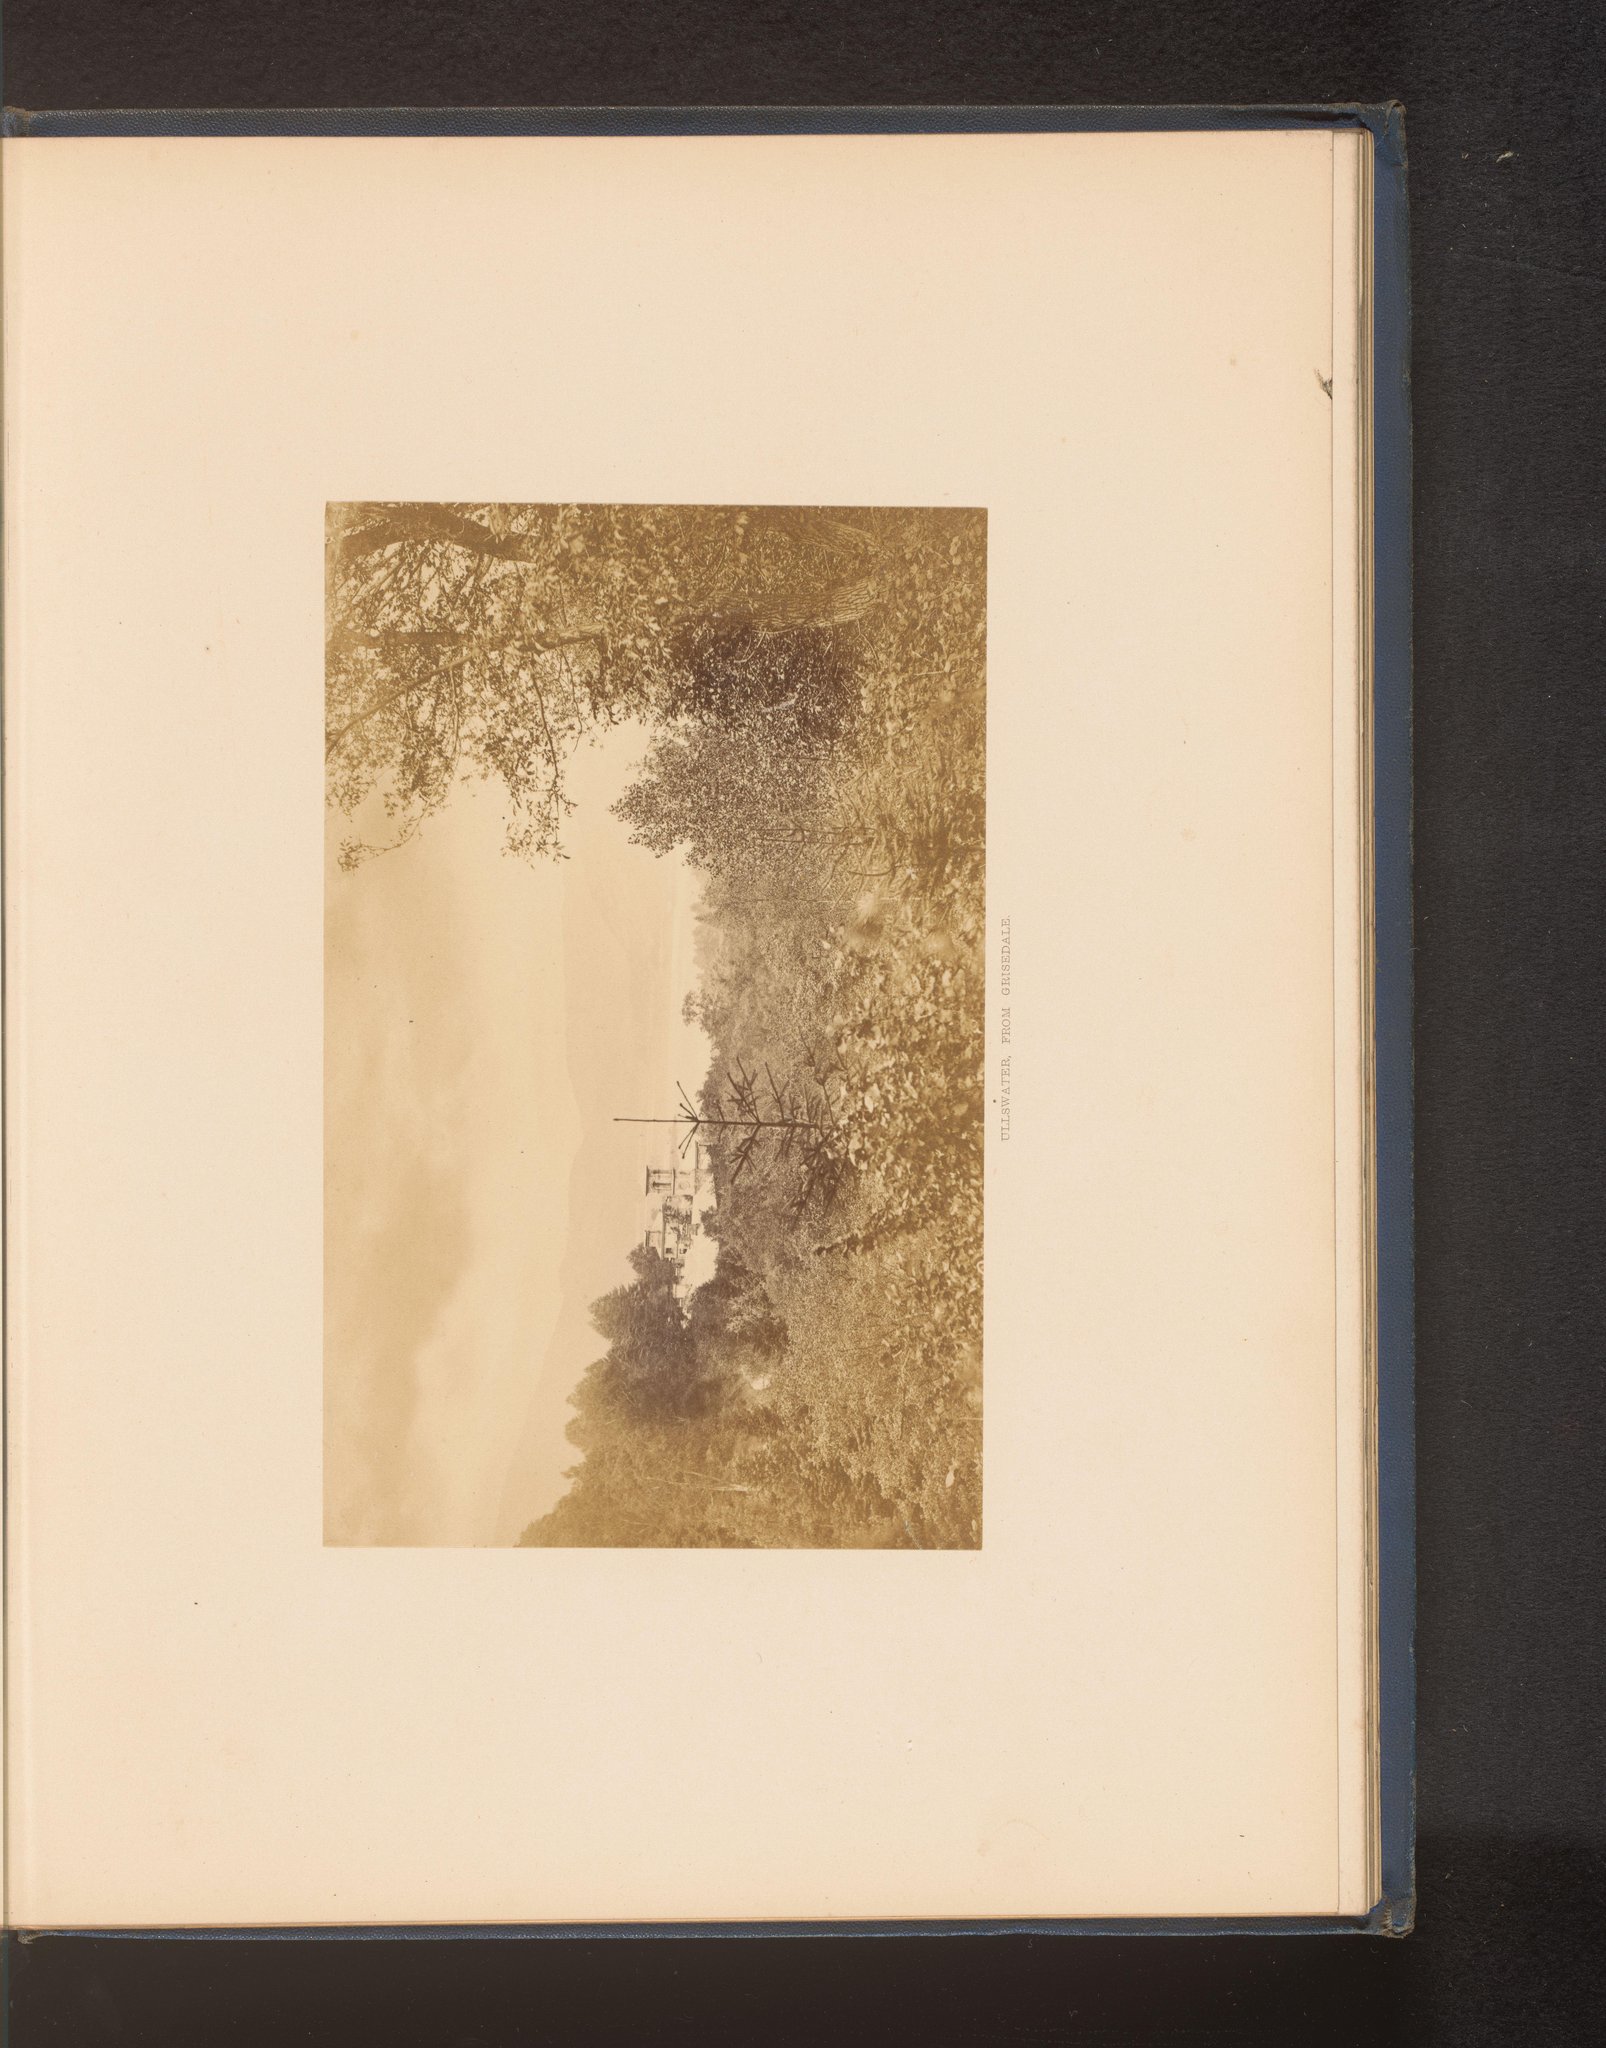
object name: photograph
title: Ullswater, from Grisedale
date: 1857-1867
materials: photographic support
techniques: albumen print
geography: lake district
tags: lake, forest, wood, mountains